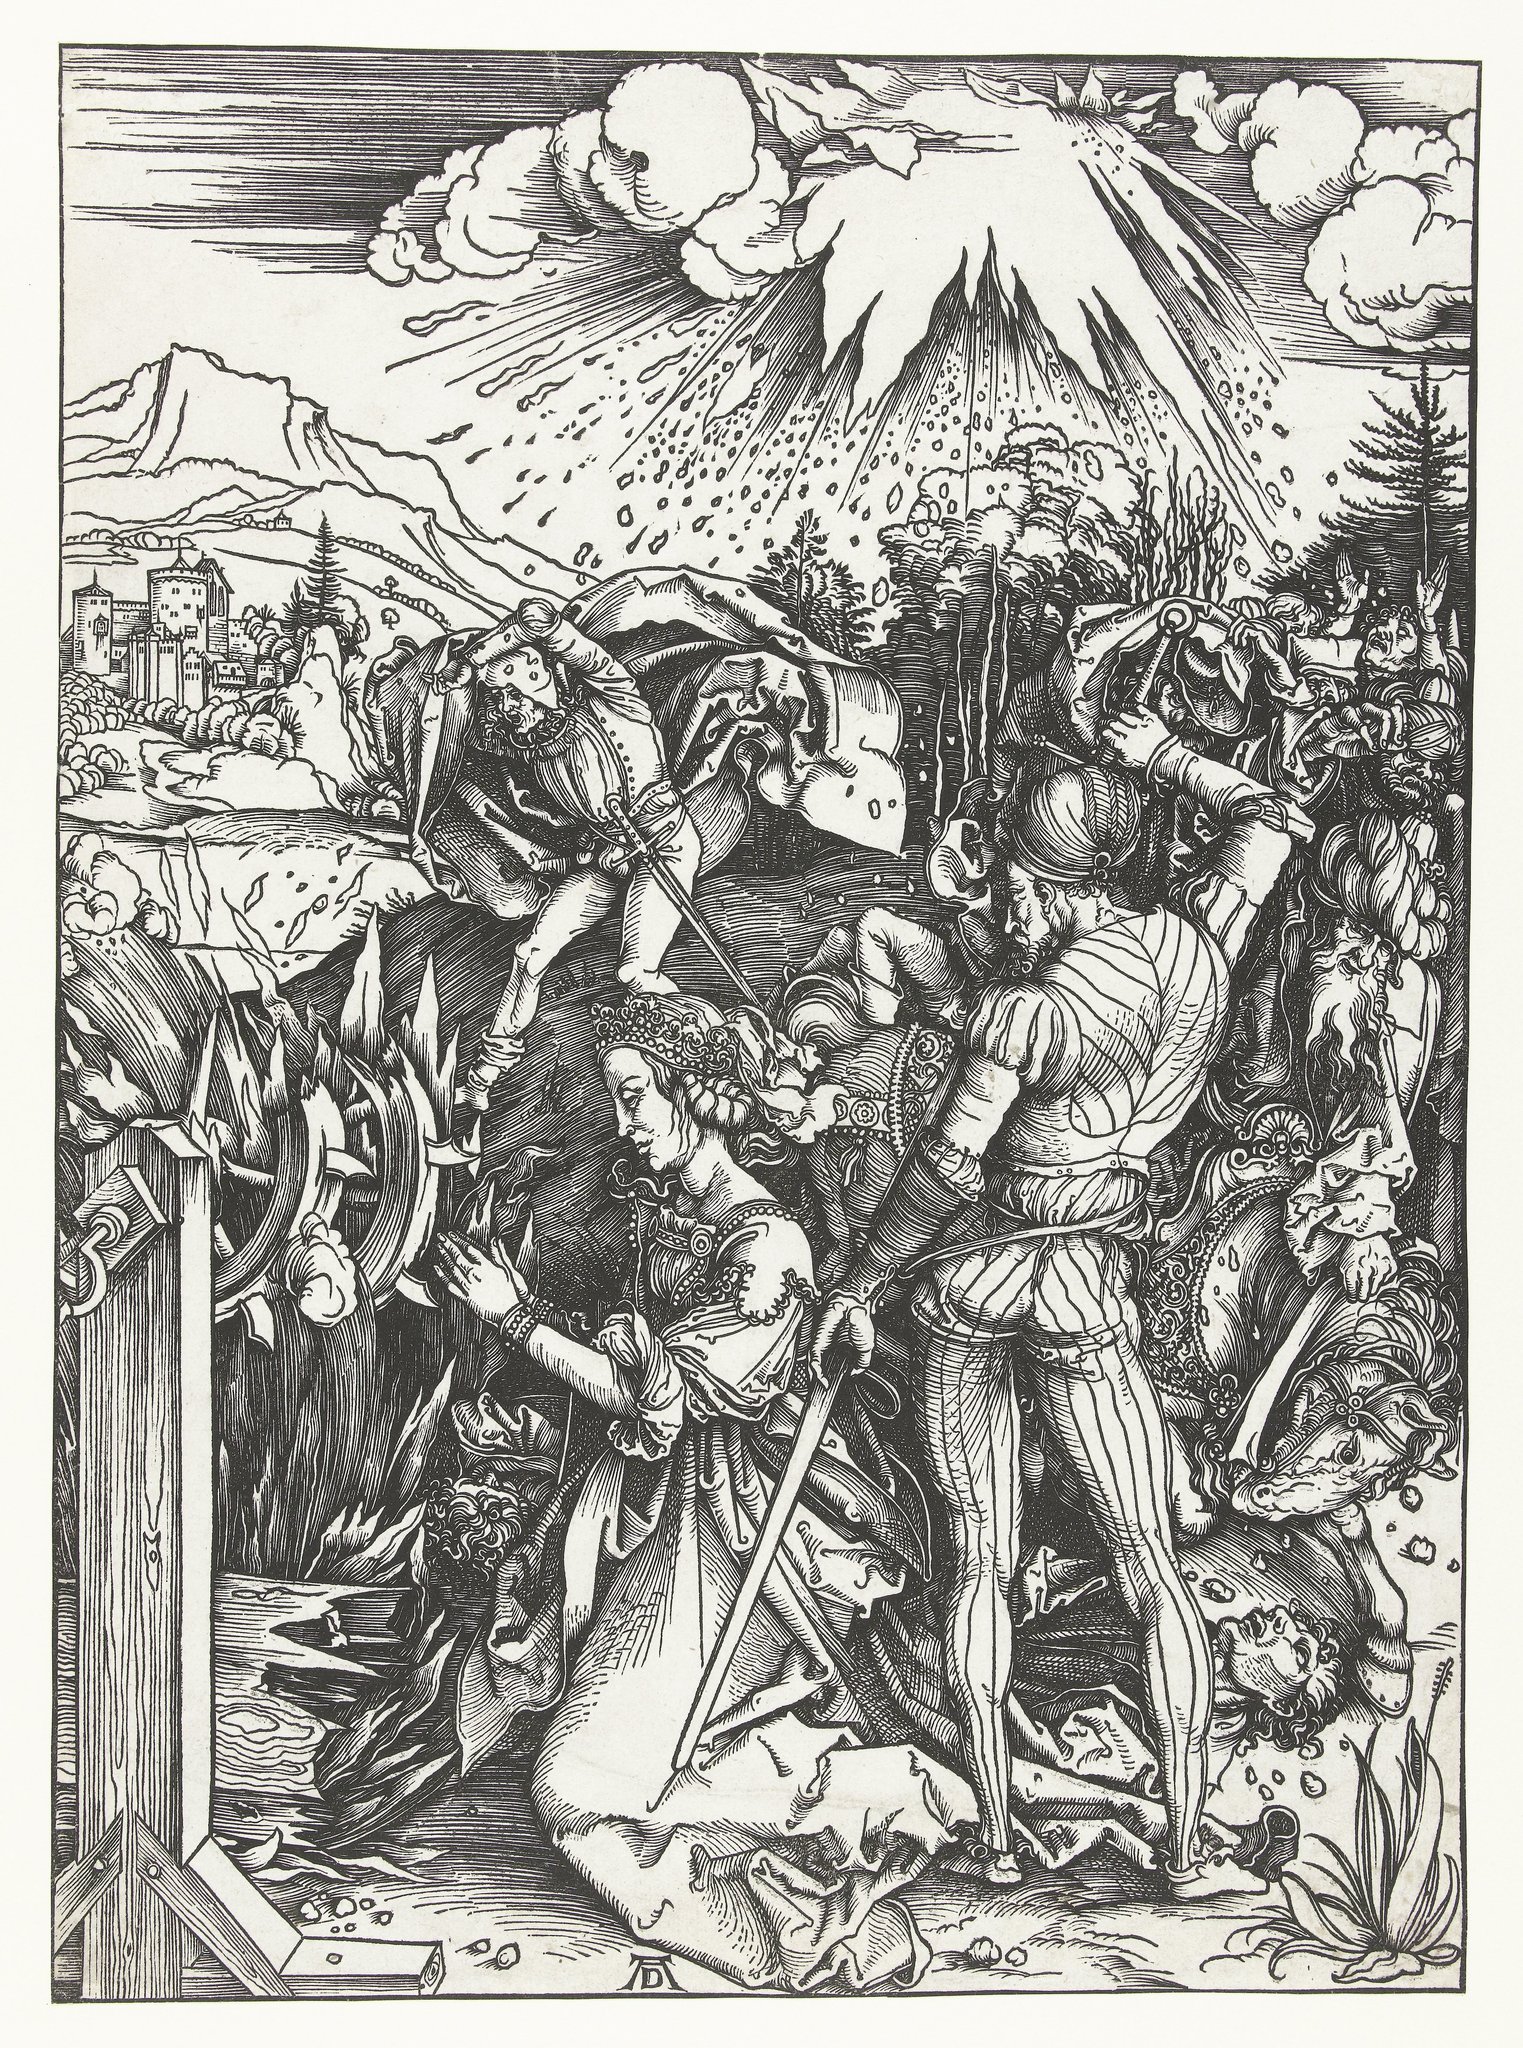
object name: print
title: Het martelaarschap van de Heilige Catharina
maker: albrecht dürer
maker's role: draughtsman, painter, print maker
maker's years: 1471-1528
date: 1496-1500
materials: paper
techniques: woodcut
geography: nuremberg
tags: the wheel of st. catherine of alexandria is destroyed by a thunderbolt from heaven, or by angels with a sword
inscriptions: collector's mark: Lugt 240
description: De Heilige Catharina knielt bij de raderen waarop zij terechtgesteld zou worden, dat juist door een vuurregen uit de hemel onklaar is gemaakt. Naast haar trekt een soldaat zijn zwaard.